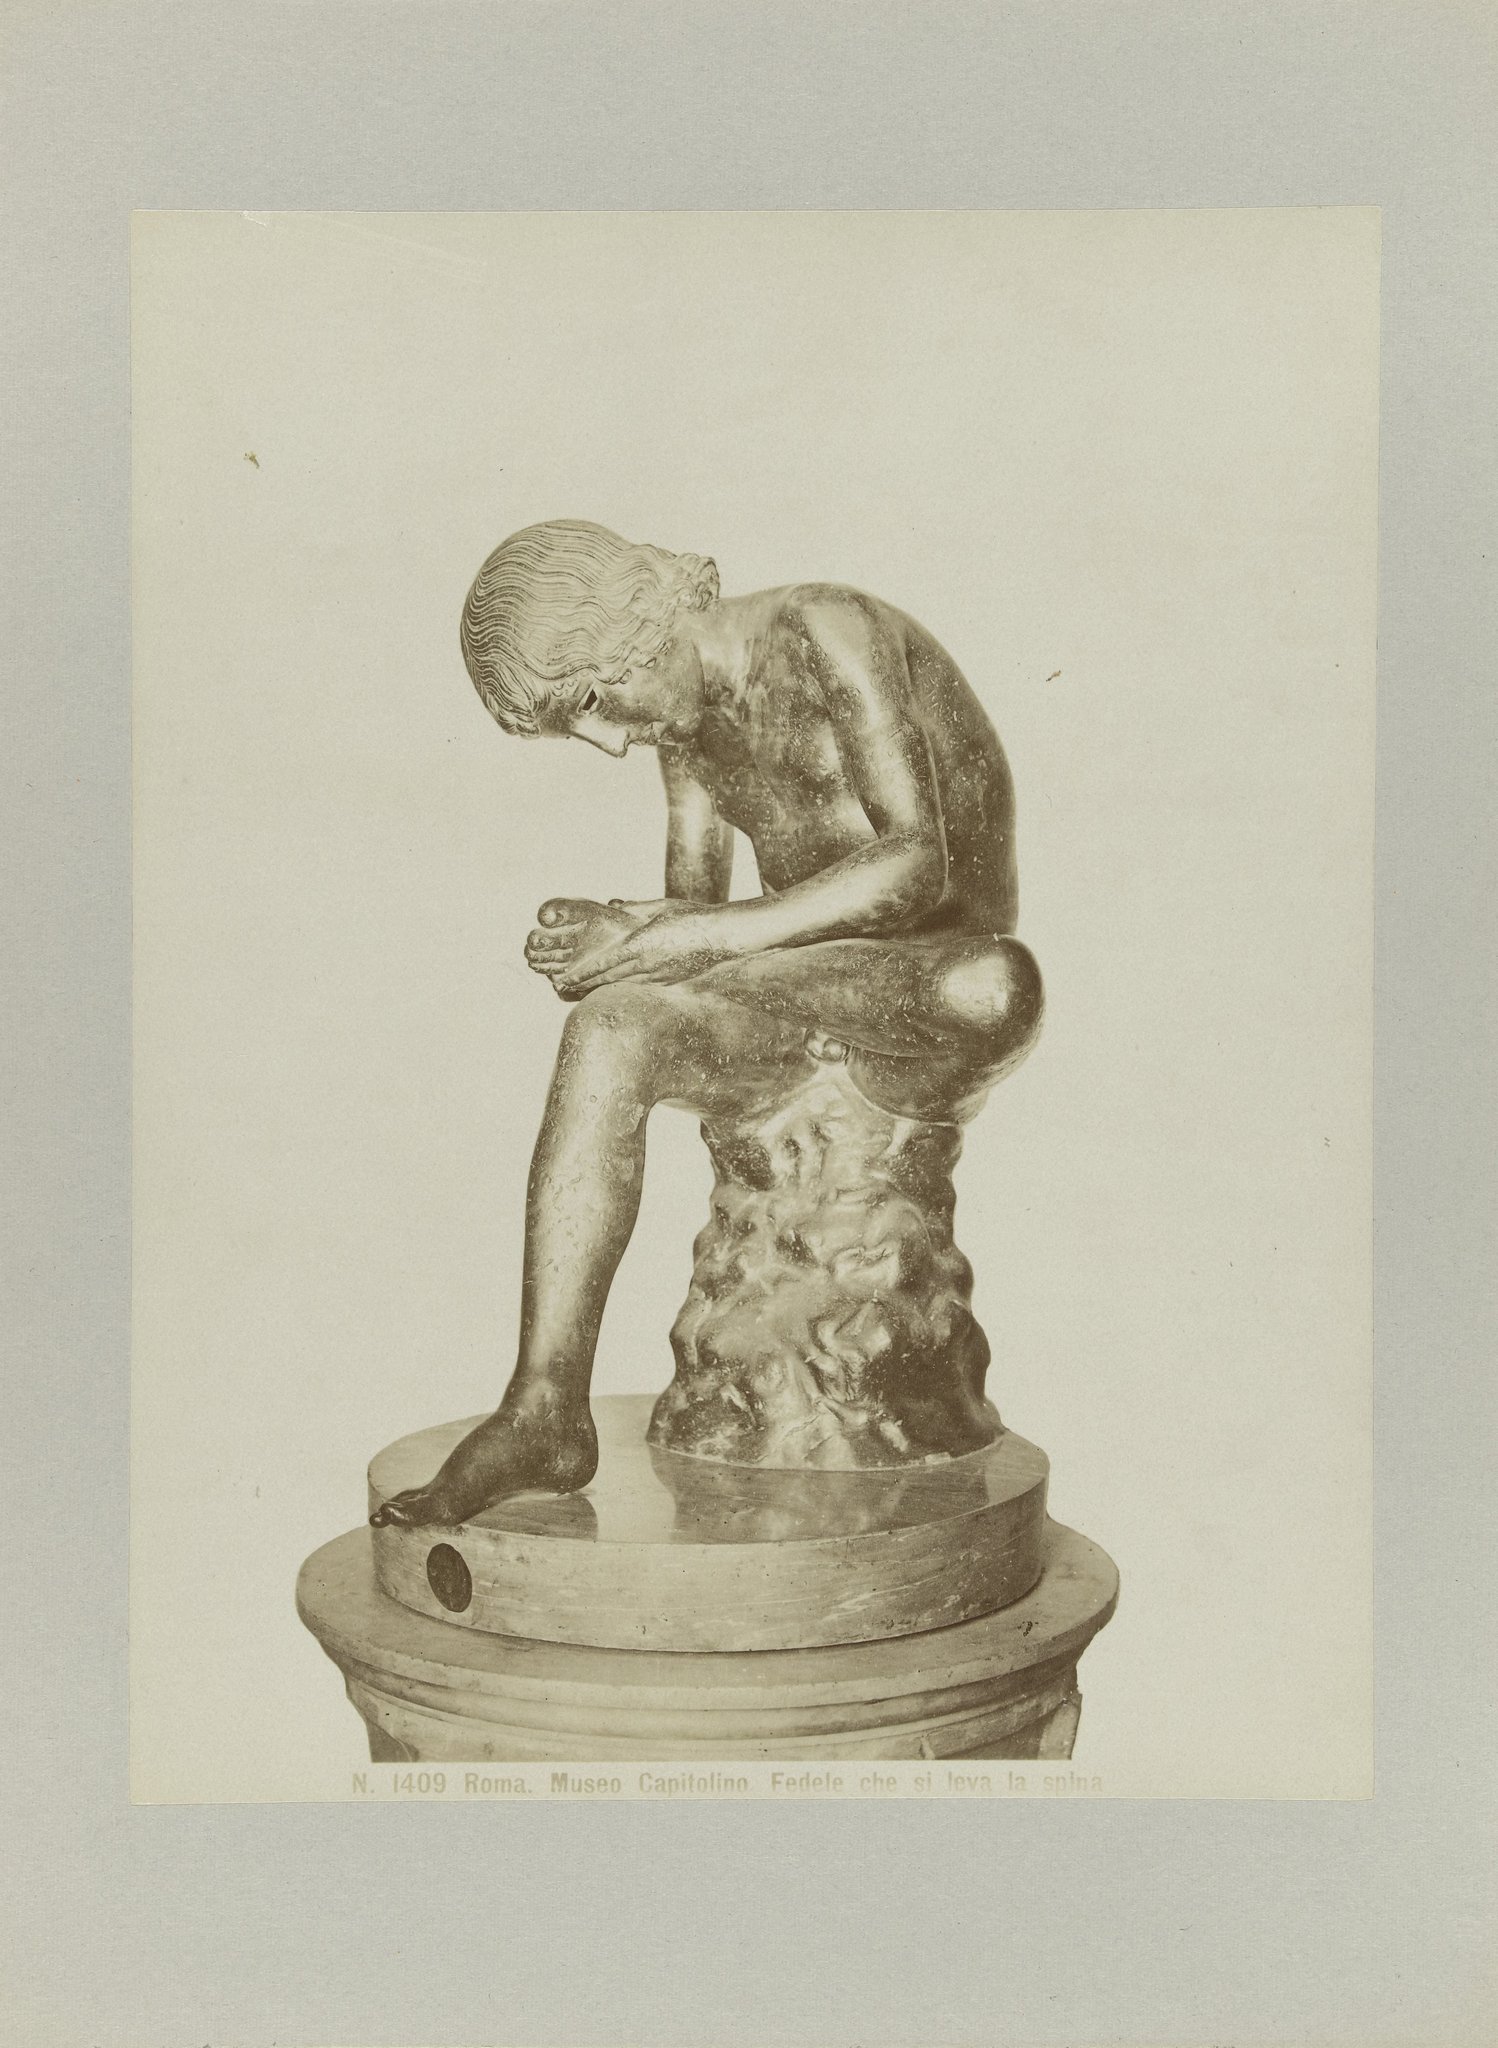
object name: photograph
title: Doornuittrekker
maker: Anonymous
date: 1880-1904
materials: cardboard, paper, photographic support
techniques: albumen print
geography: rome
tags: rome